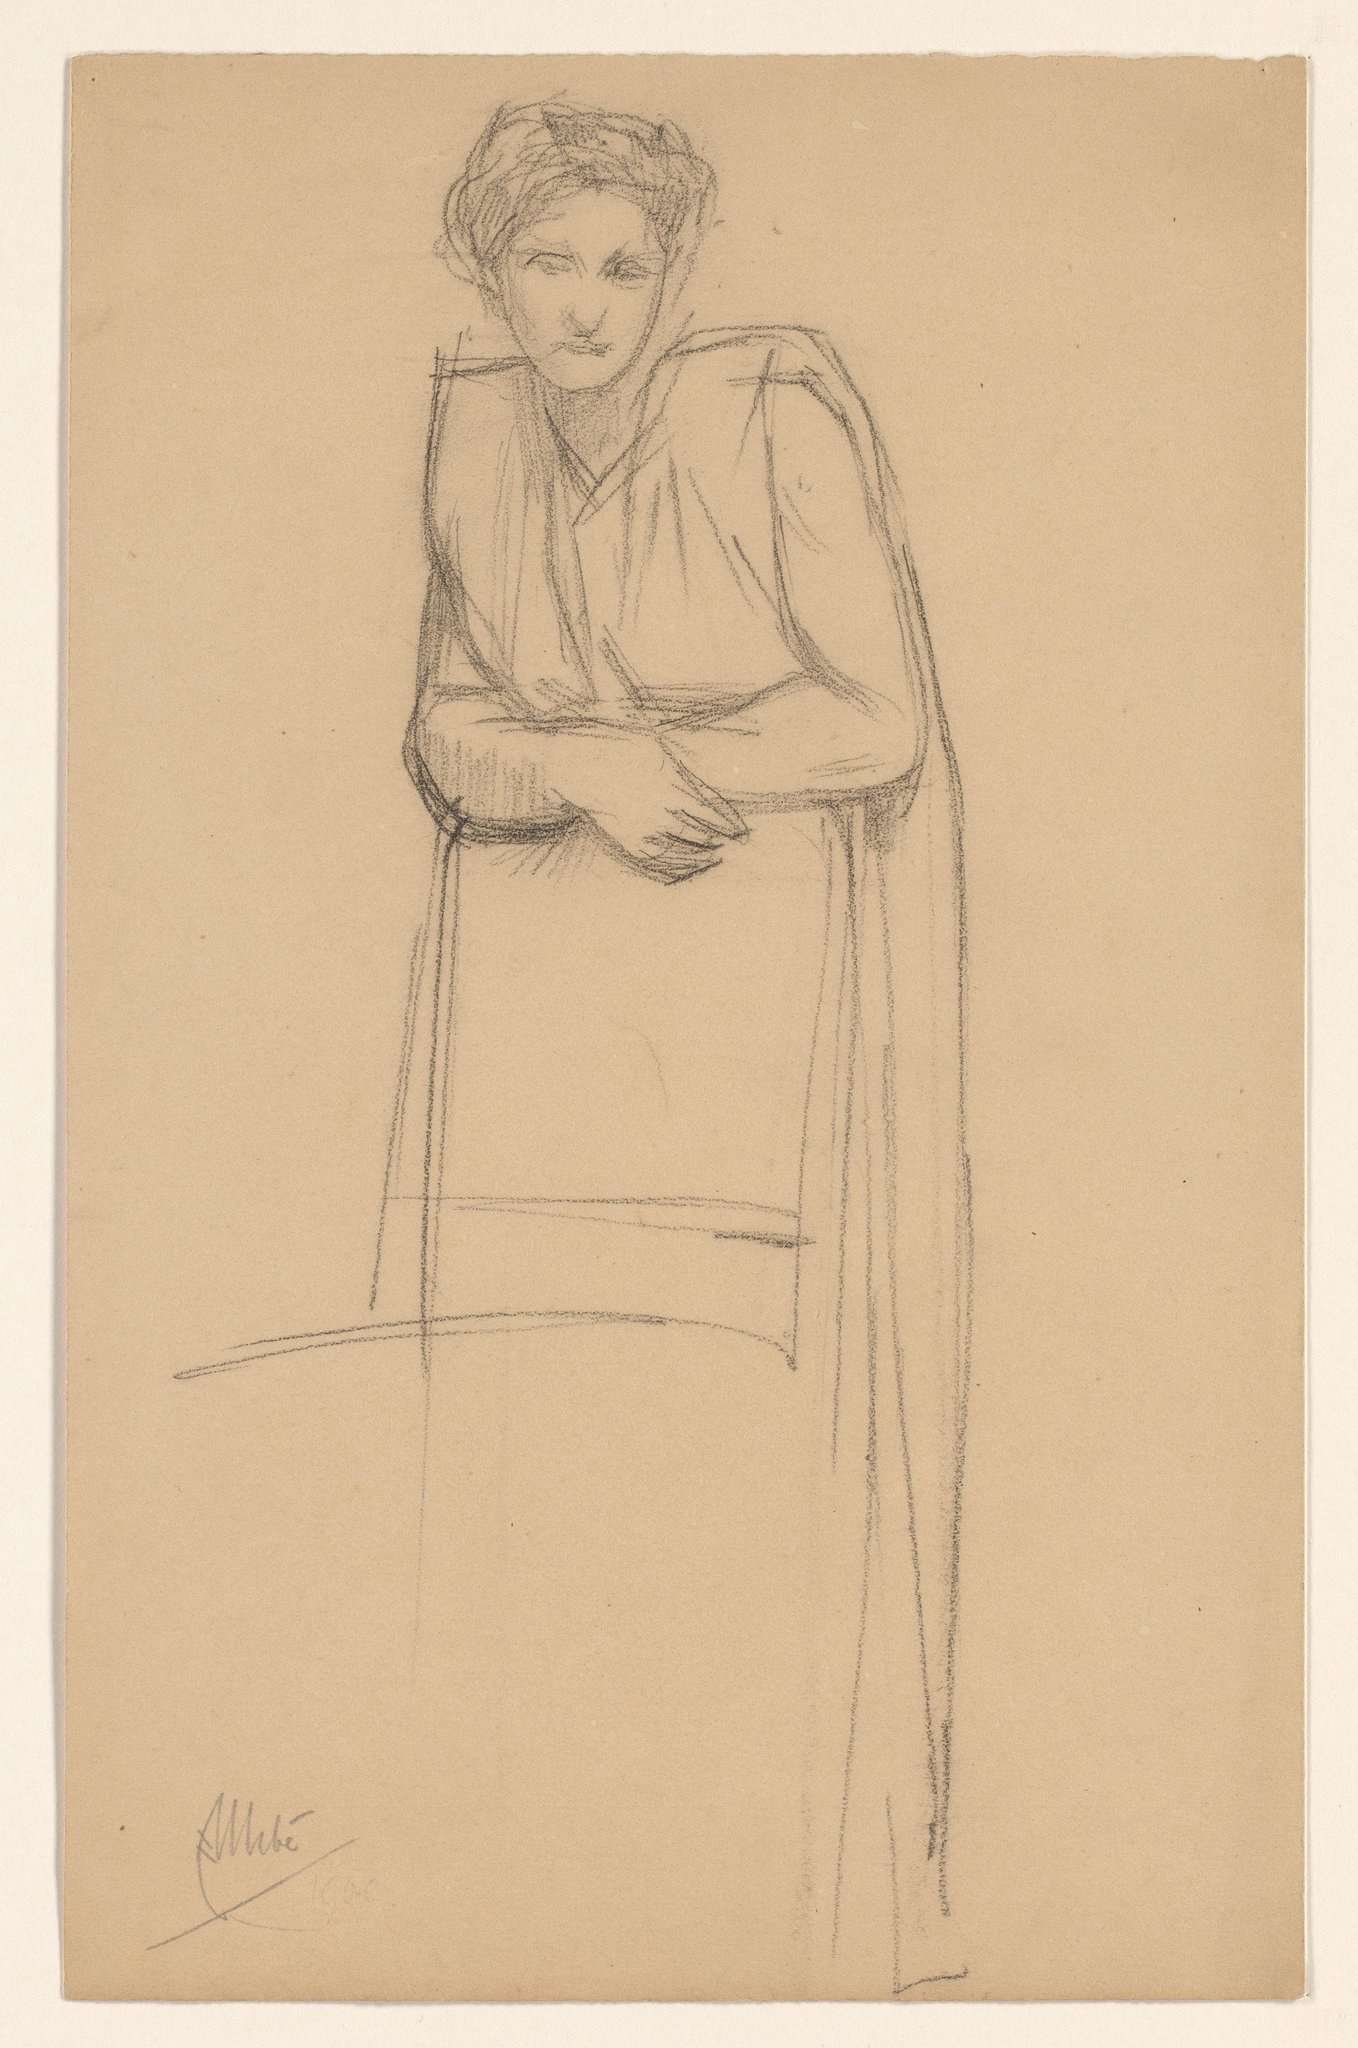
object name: drawing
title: Portret van een vrouw, staande achter een stoel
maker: august allebé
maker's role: draughtsman, print maker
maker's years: 1838-1927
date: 1848-1927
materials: chalk, paper